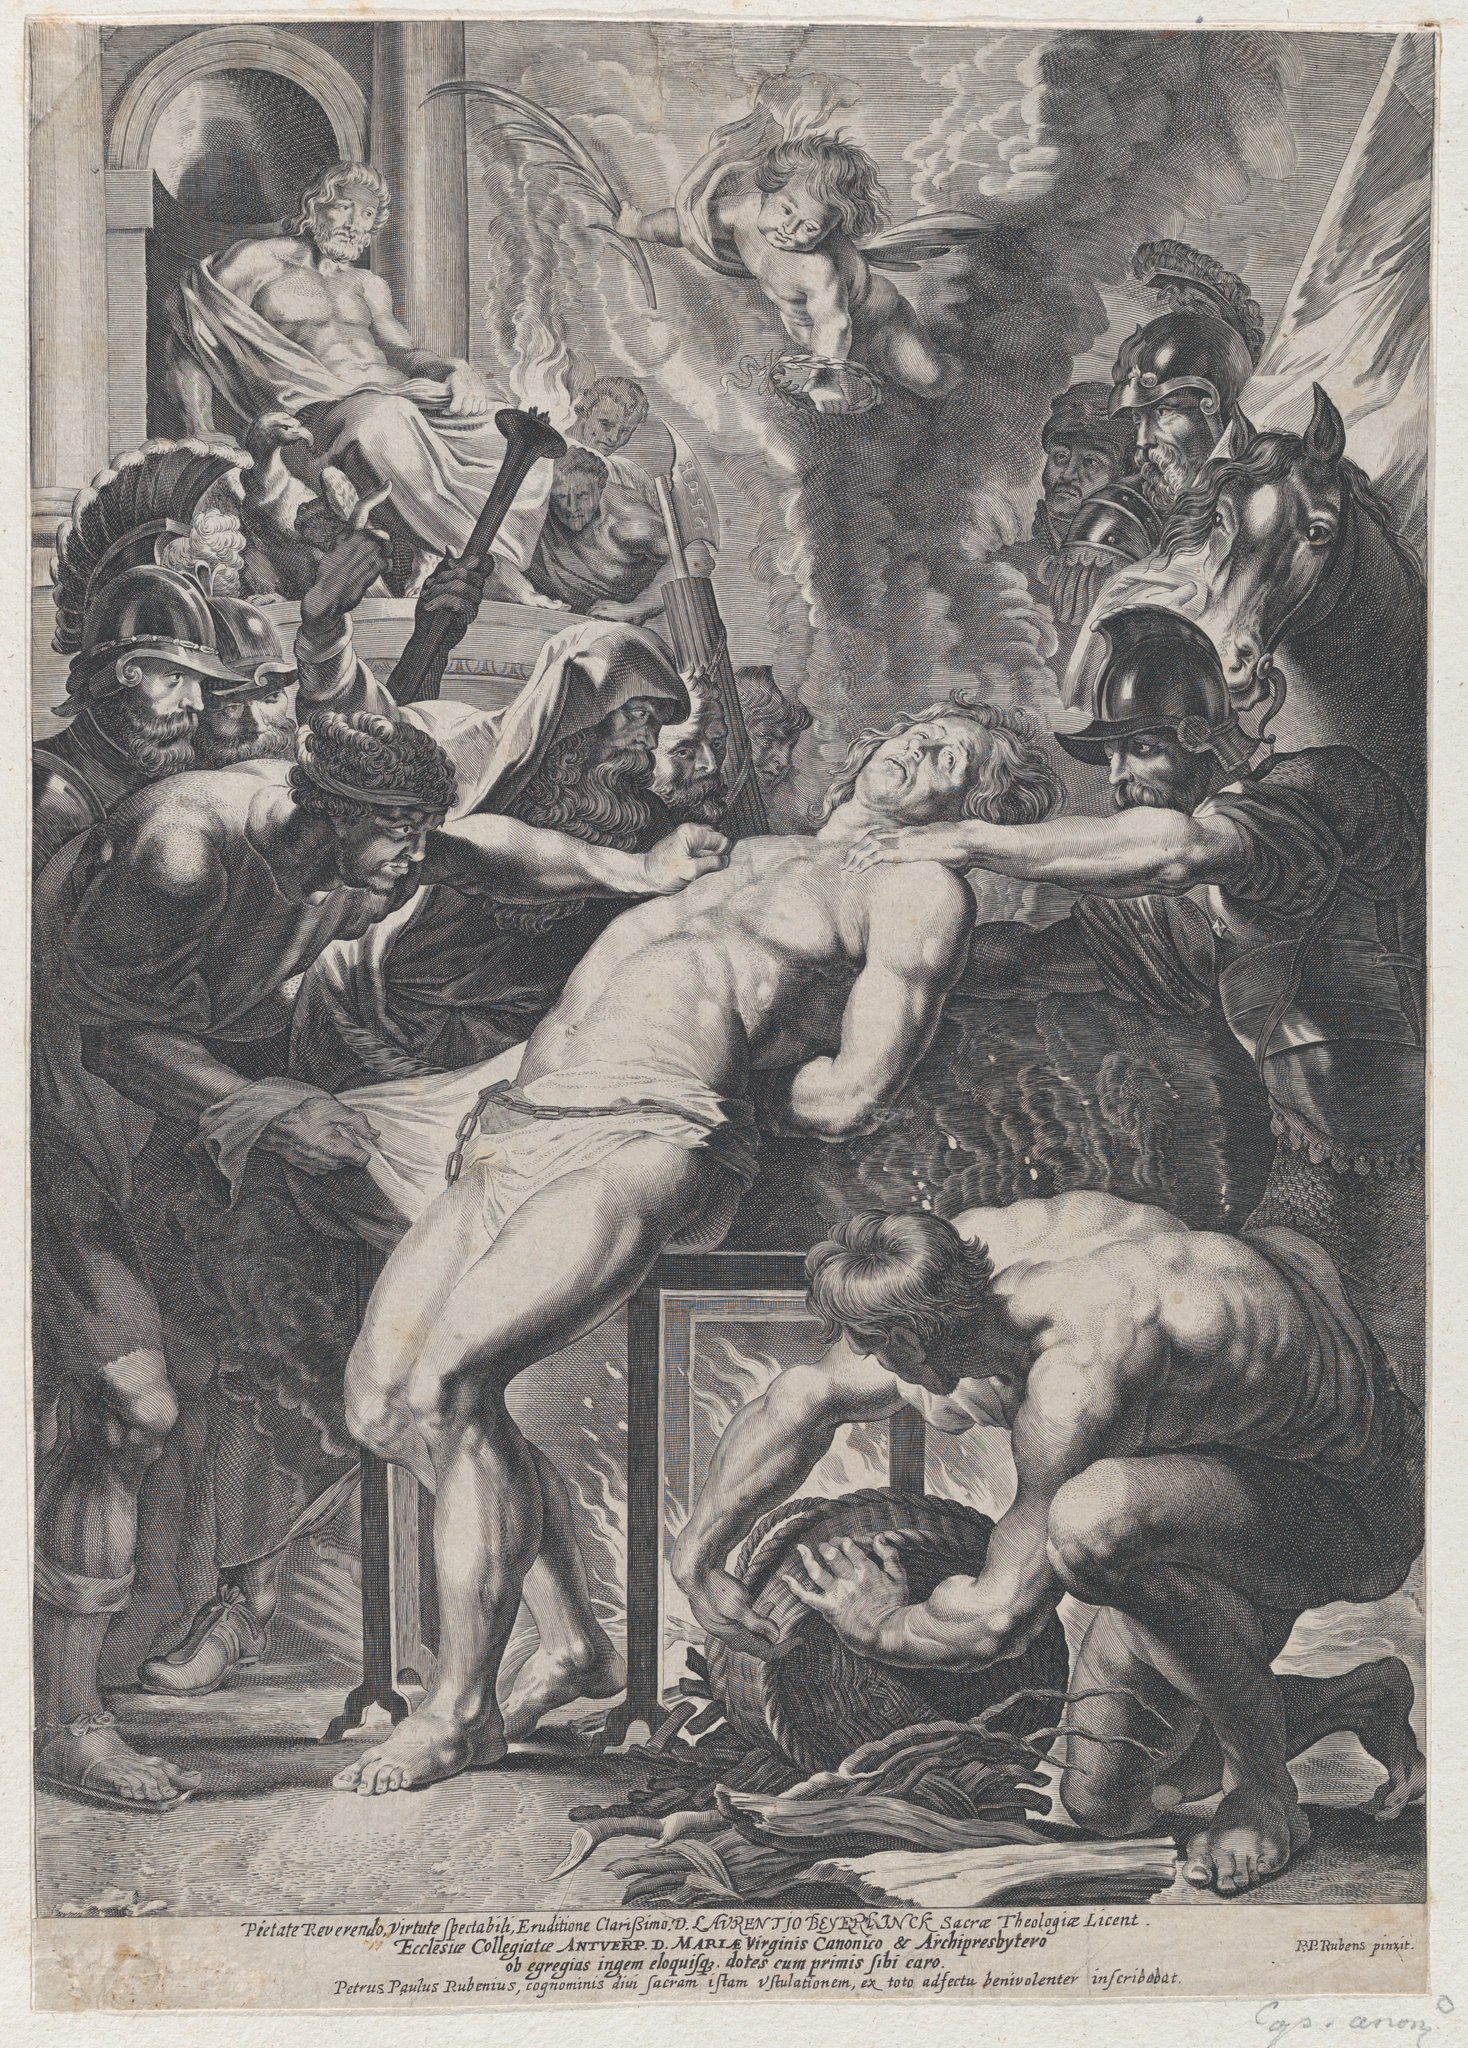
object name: print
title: Saint Lawrence at the Stake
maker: Anonymous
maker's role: artist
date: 1621-1750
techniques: engraving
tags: soldiers,men,angels,saint lawrence